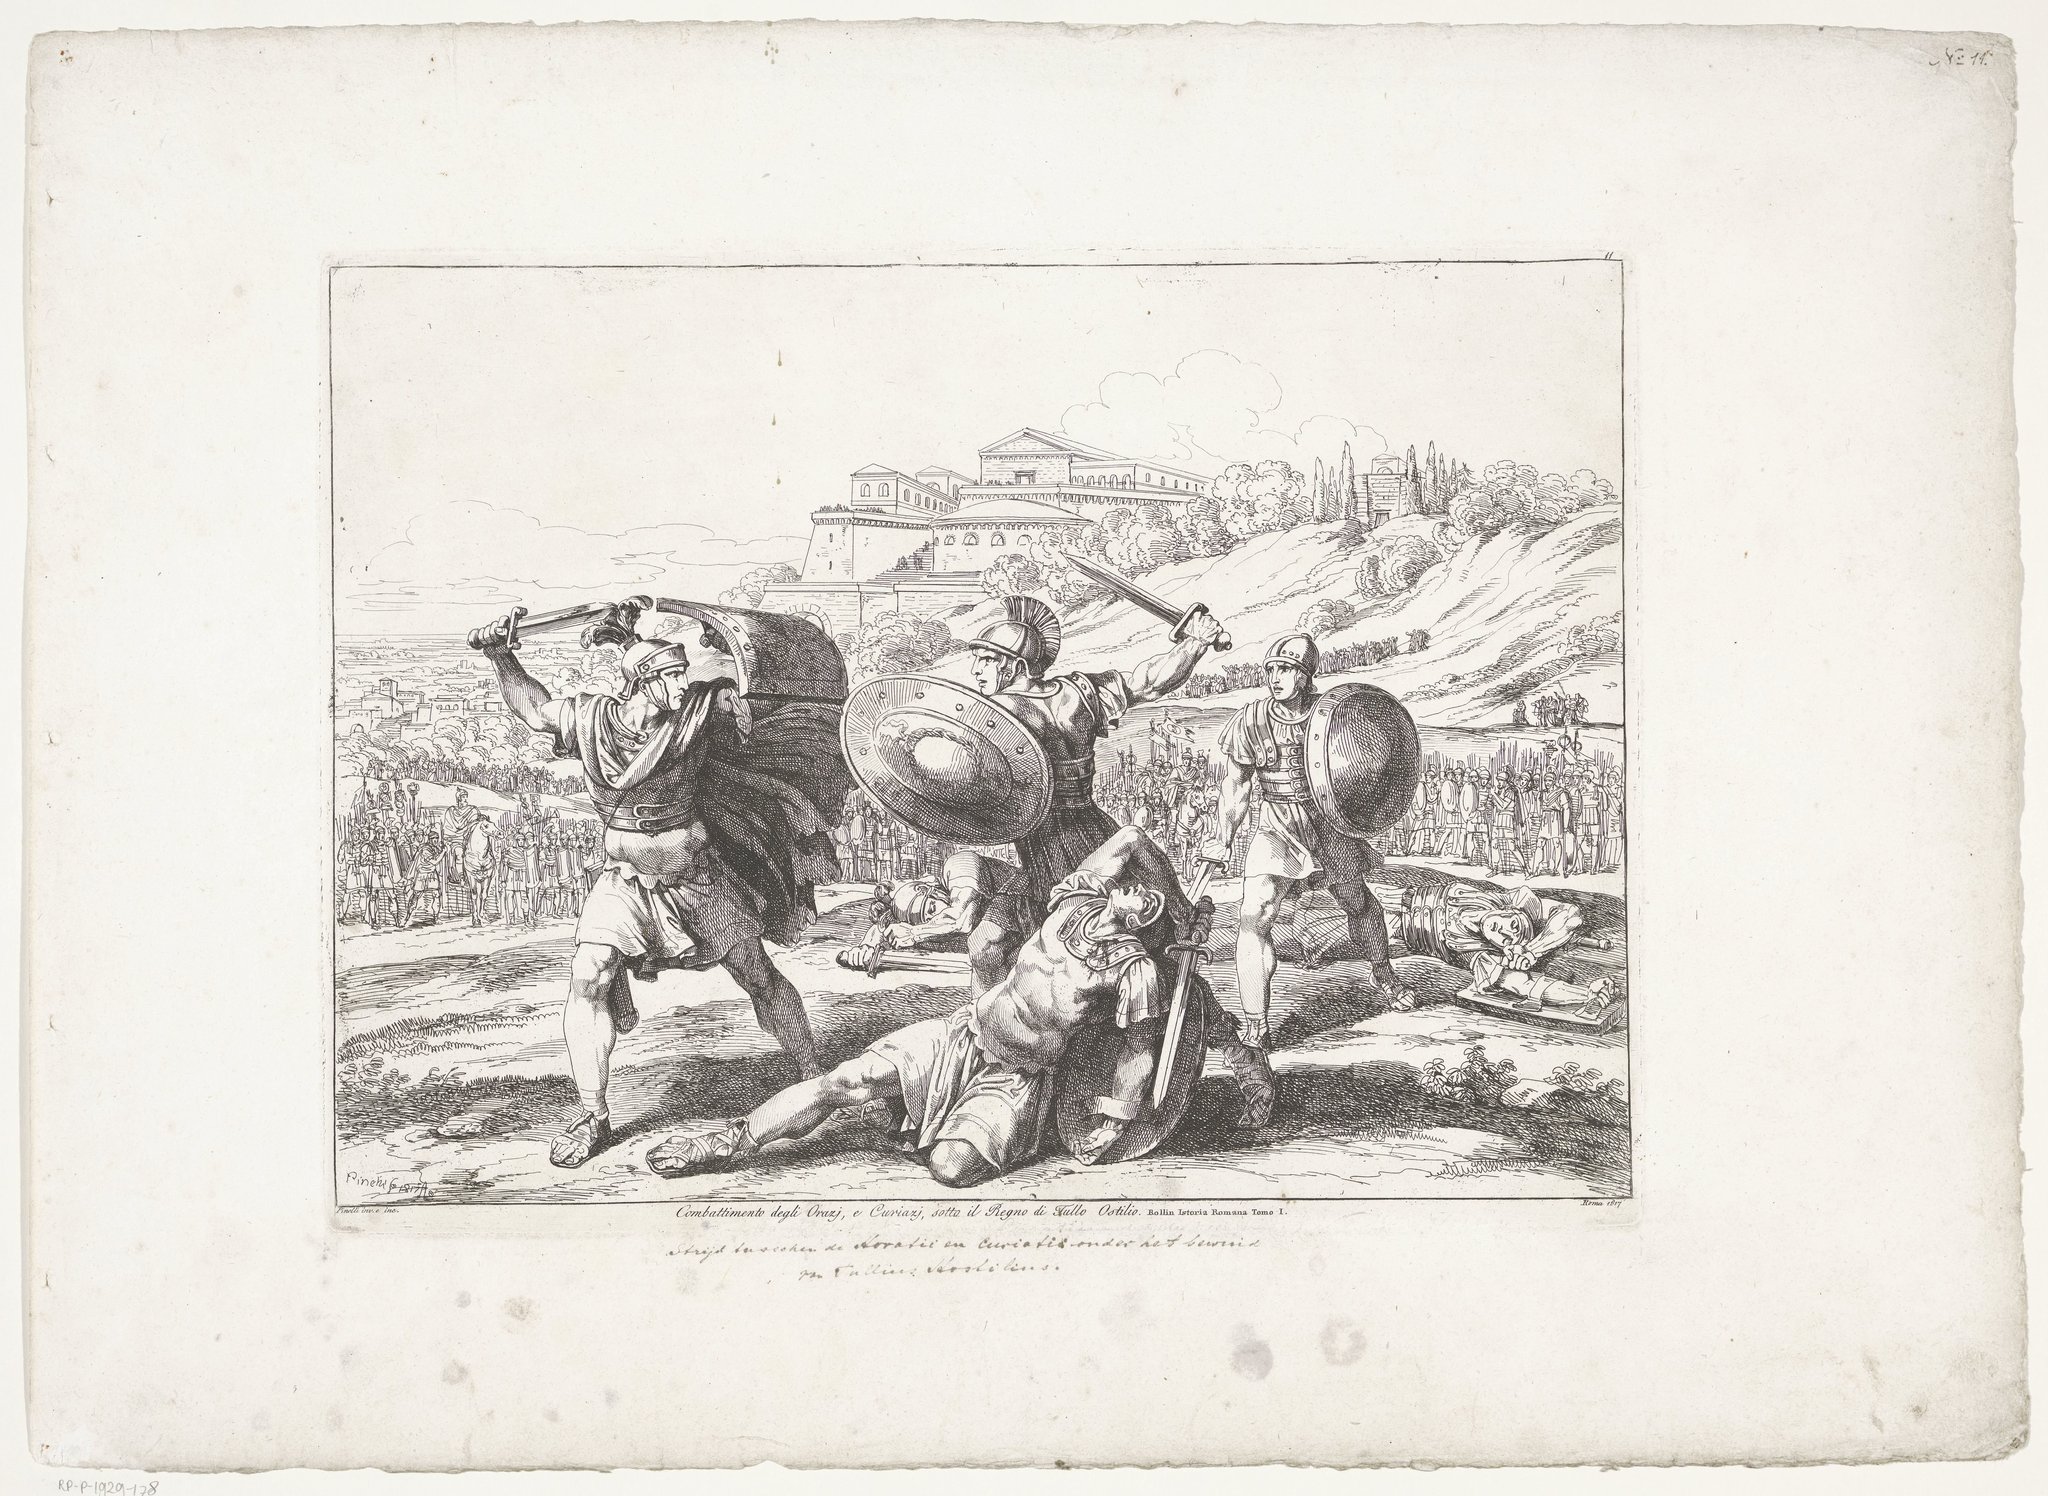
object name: print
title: Geschiedenis van het Romeinse Rijk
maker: bartolomeo pinelli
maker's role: draughtsman, print maker, sculptor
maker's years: 1781-1835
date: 1817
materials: paper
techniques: etching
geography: rome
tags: two horatii being killed, the surviving brother defeats the three curiatii one by one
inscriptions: collector's mark: Lugt 2228, inscription: ‘Strijd tusschen de Horatii en Curiatii onder het bewind / van Tullius Hostilius.’, number: ‘No 11.’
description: Duel tussen de Horatii en Curiatii, twee drielingen van respectievelijk Romeinse en Albaanse komaf. Hier doodt Publius Horatius de gewonde Curiatii een voor een. Romeinen moedigen hem aan.